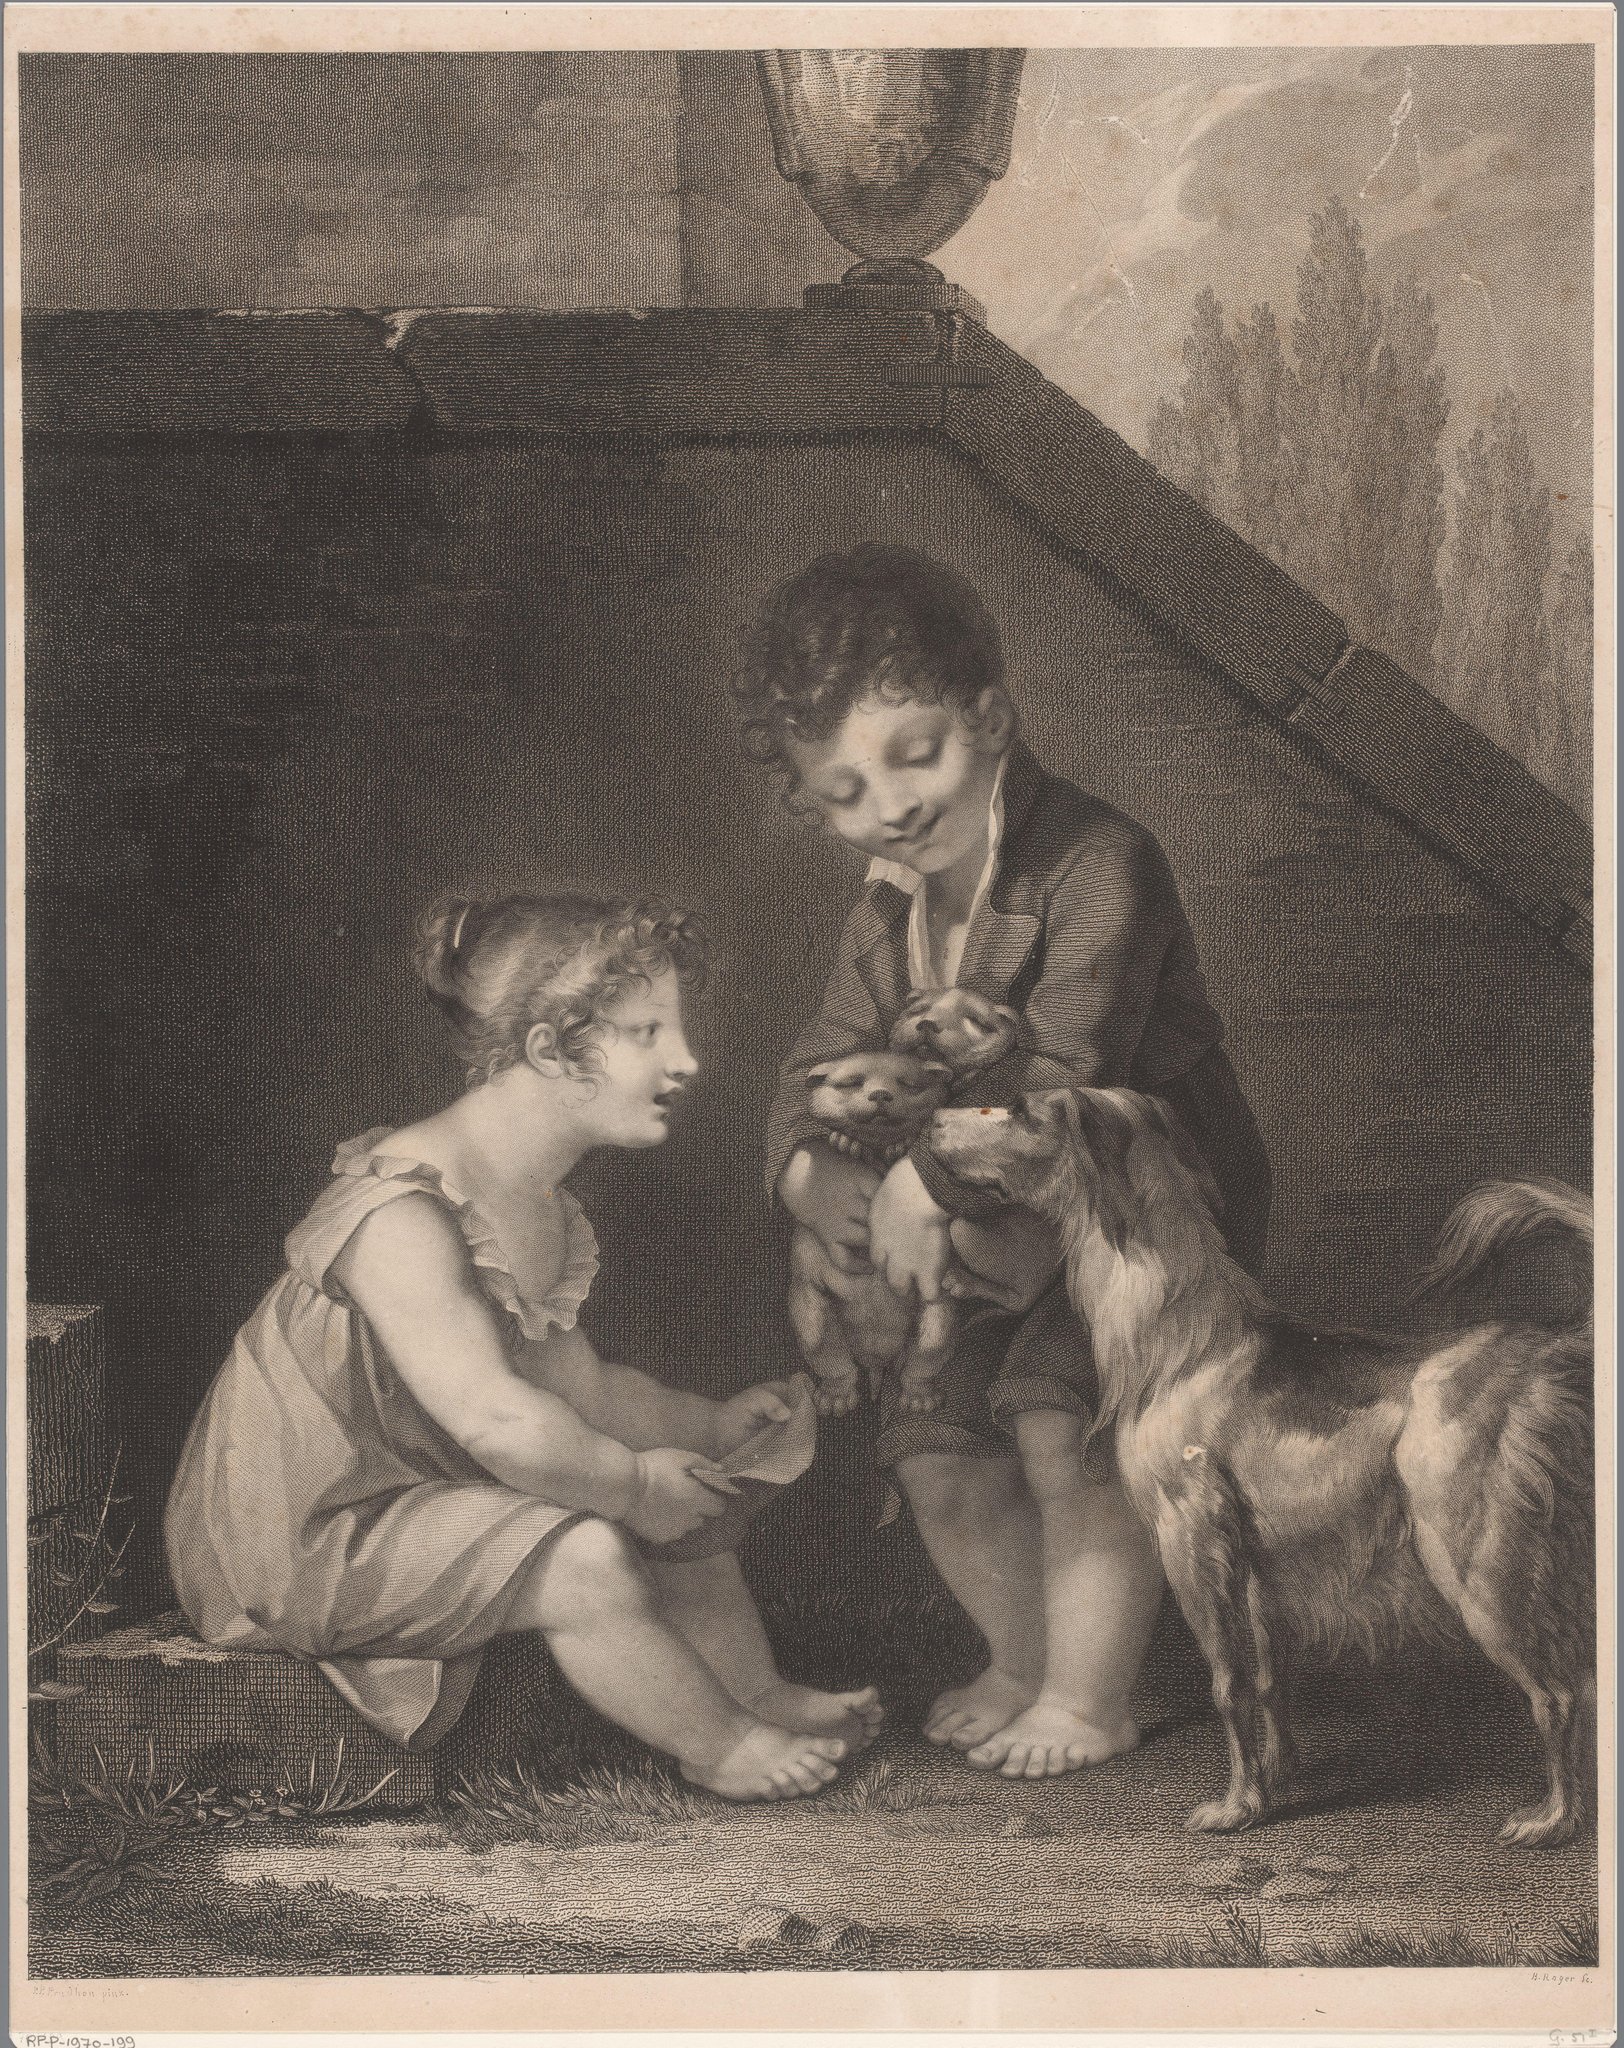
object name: print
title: Oh, les jolis petits chiens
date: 1777-1841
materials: paper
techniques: engraving, etching, roulette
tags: child, child playing with animals, dog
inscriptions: collector's mark: Lugt 2228, collector's mark: Lugt 2760